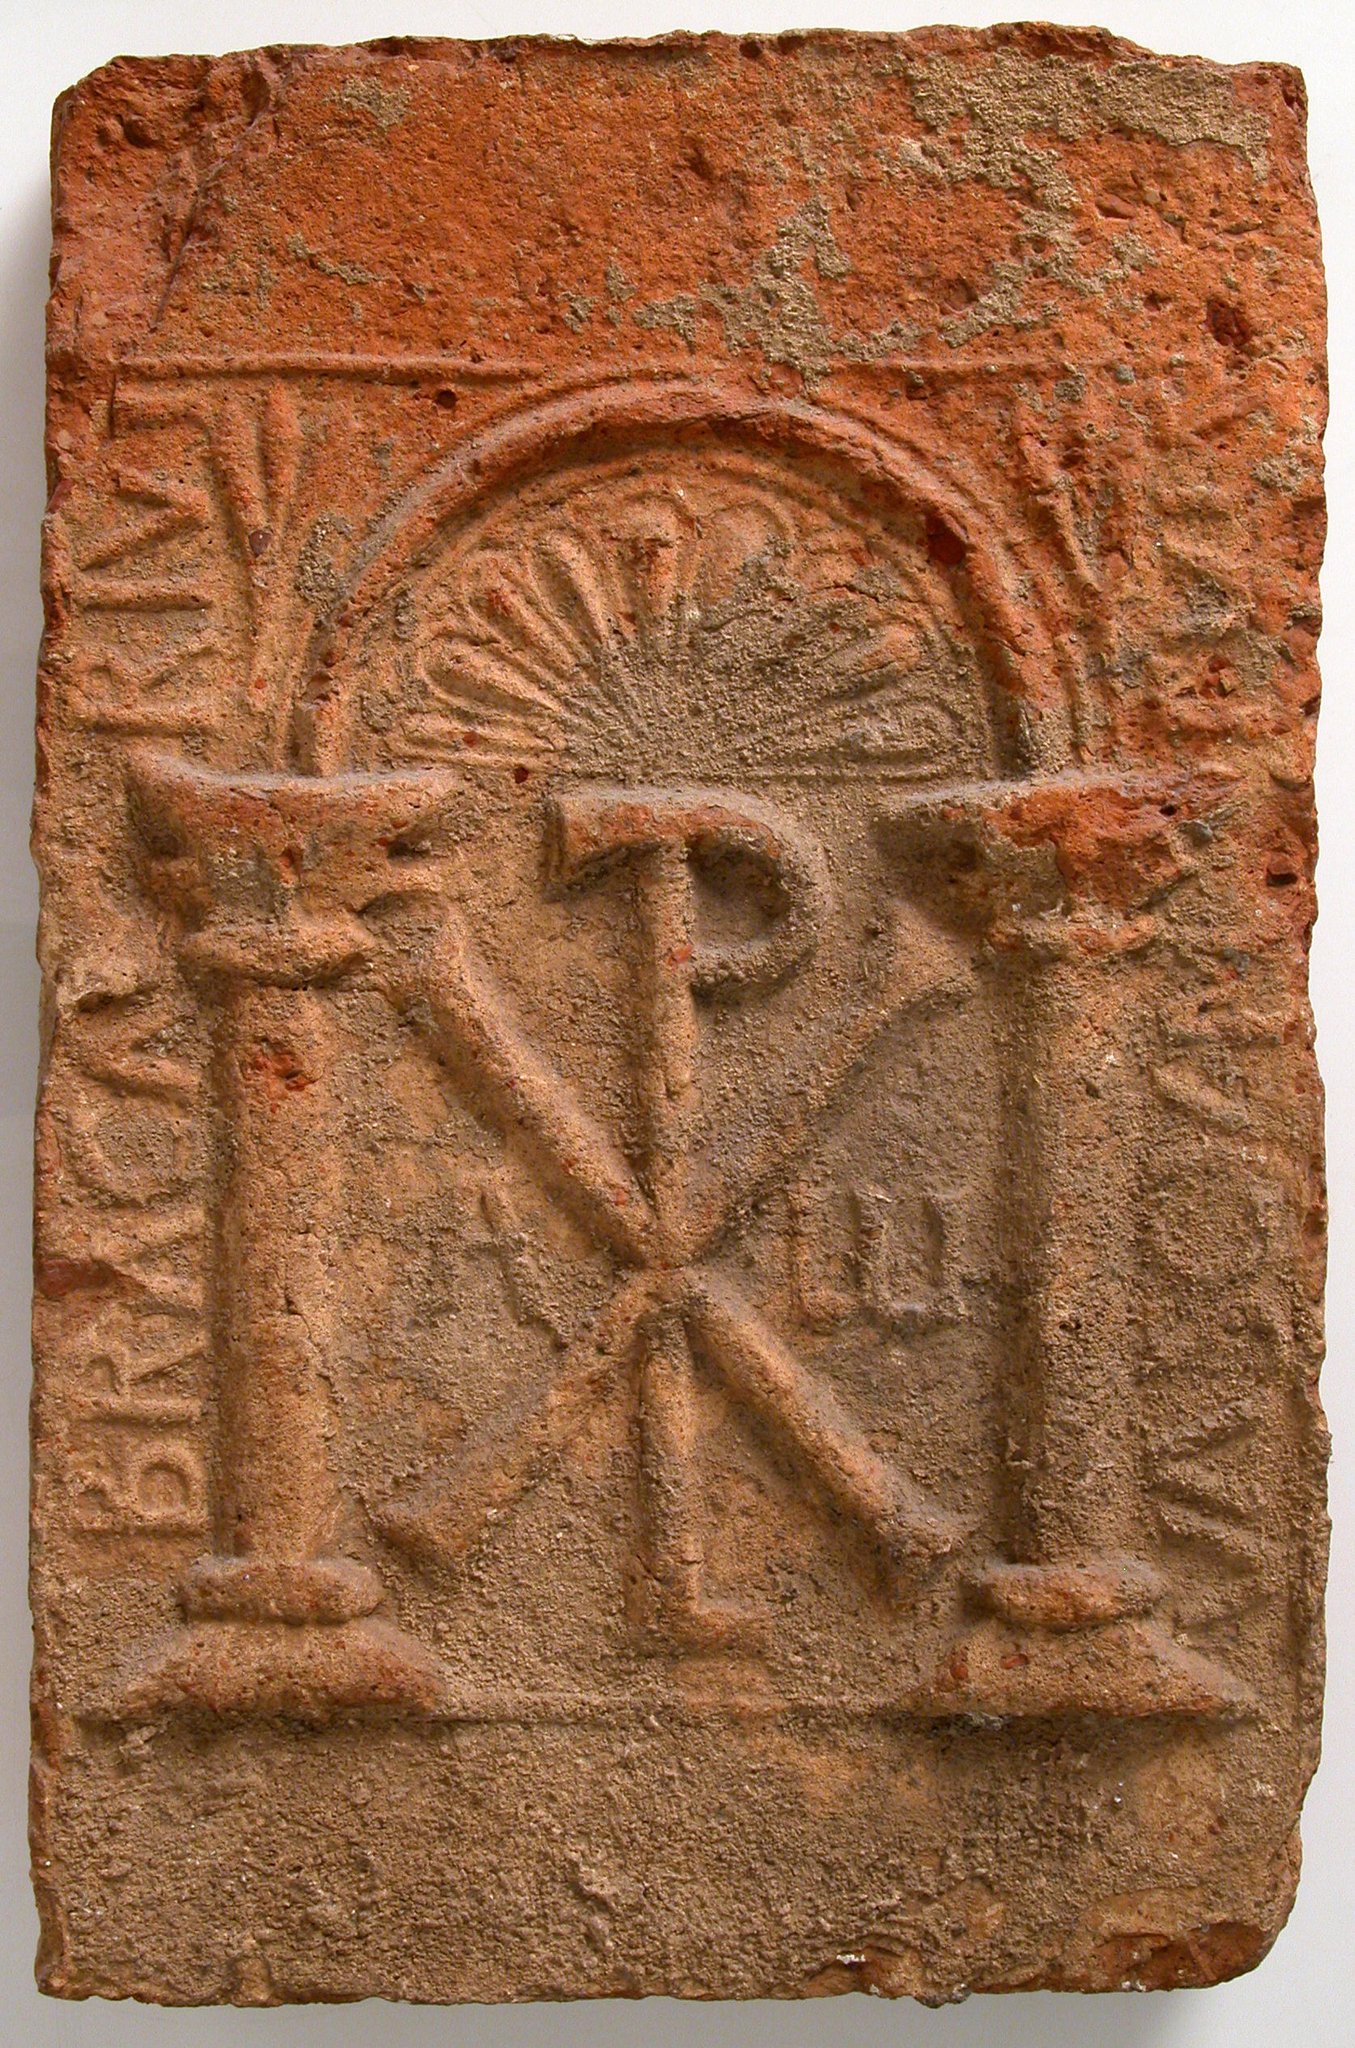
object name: relief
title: Terracotta Tomb Plaque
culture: spanish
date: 400-800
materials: terracotta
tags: arches